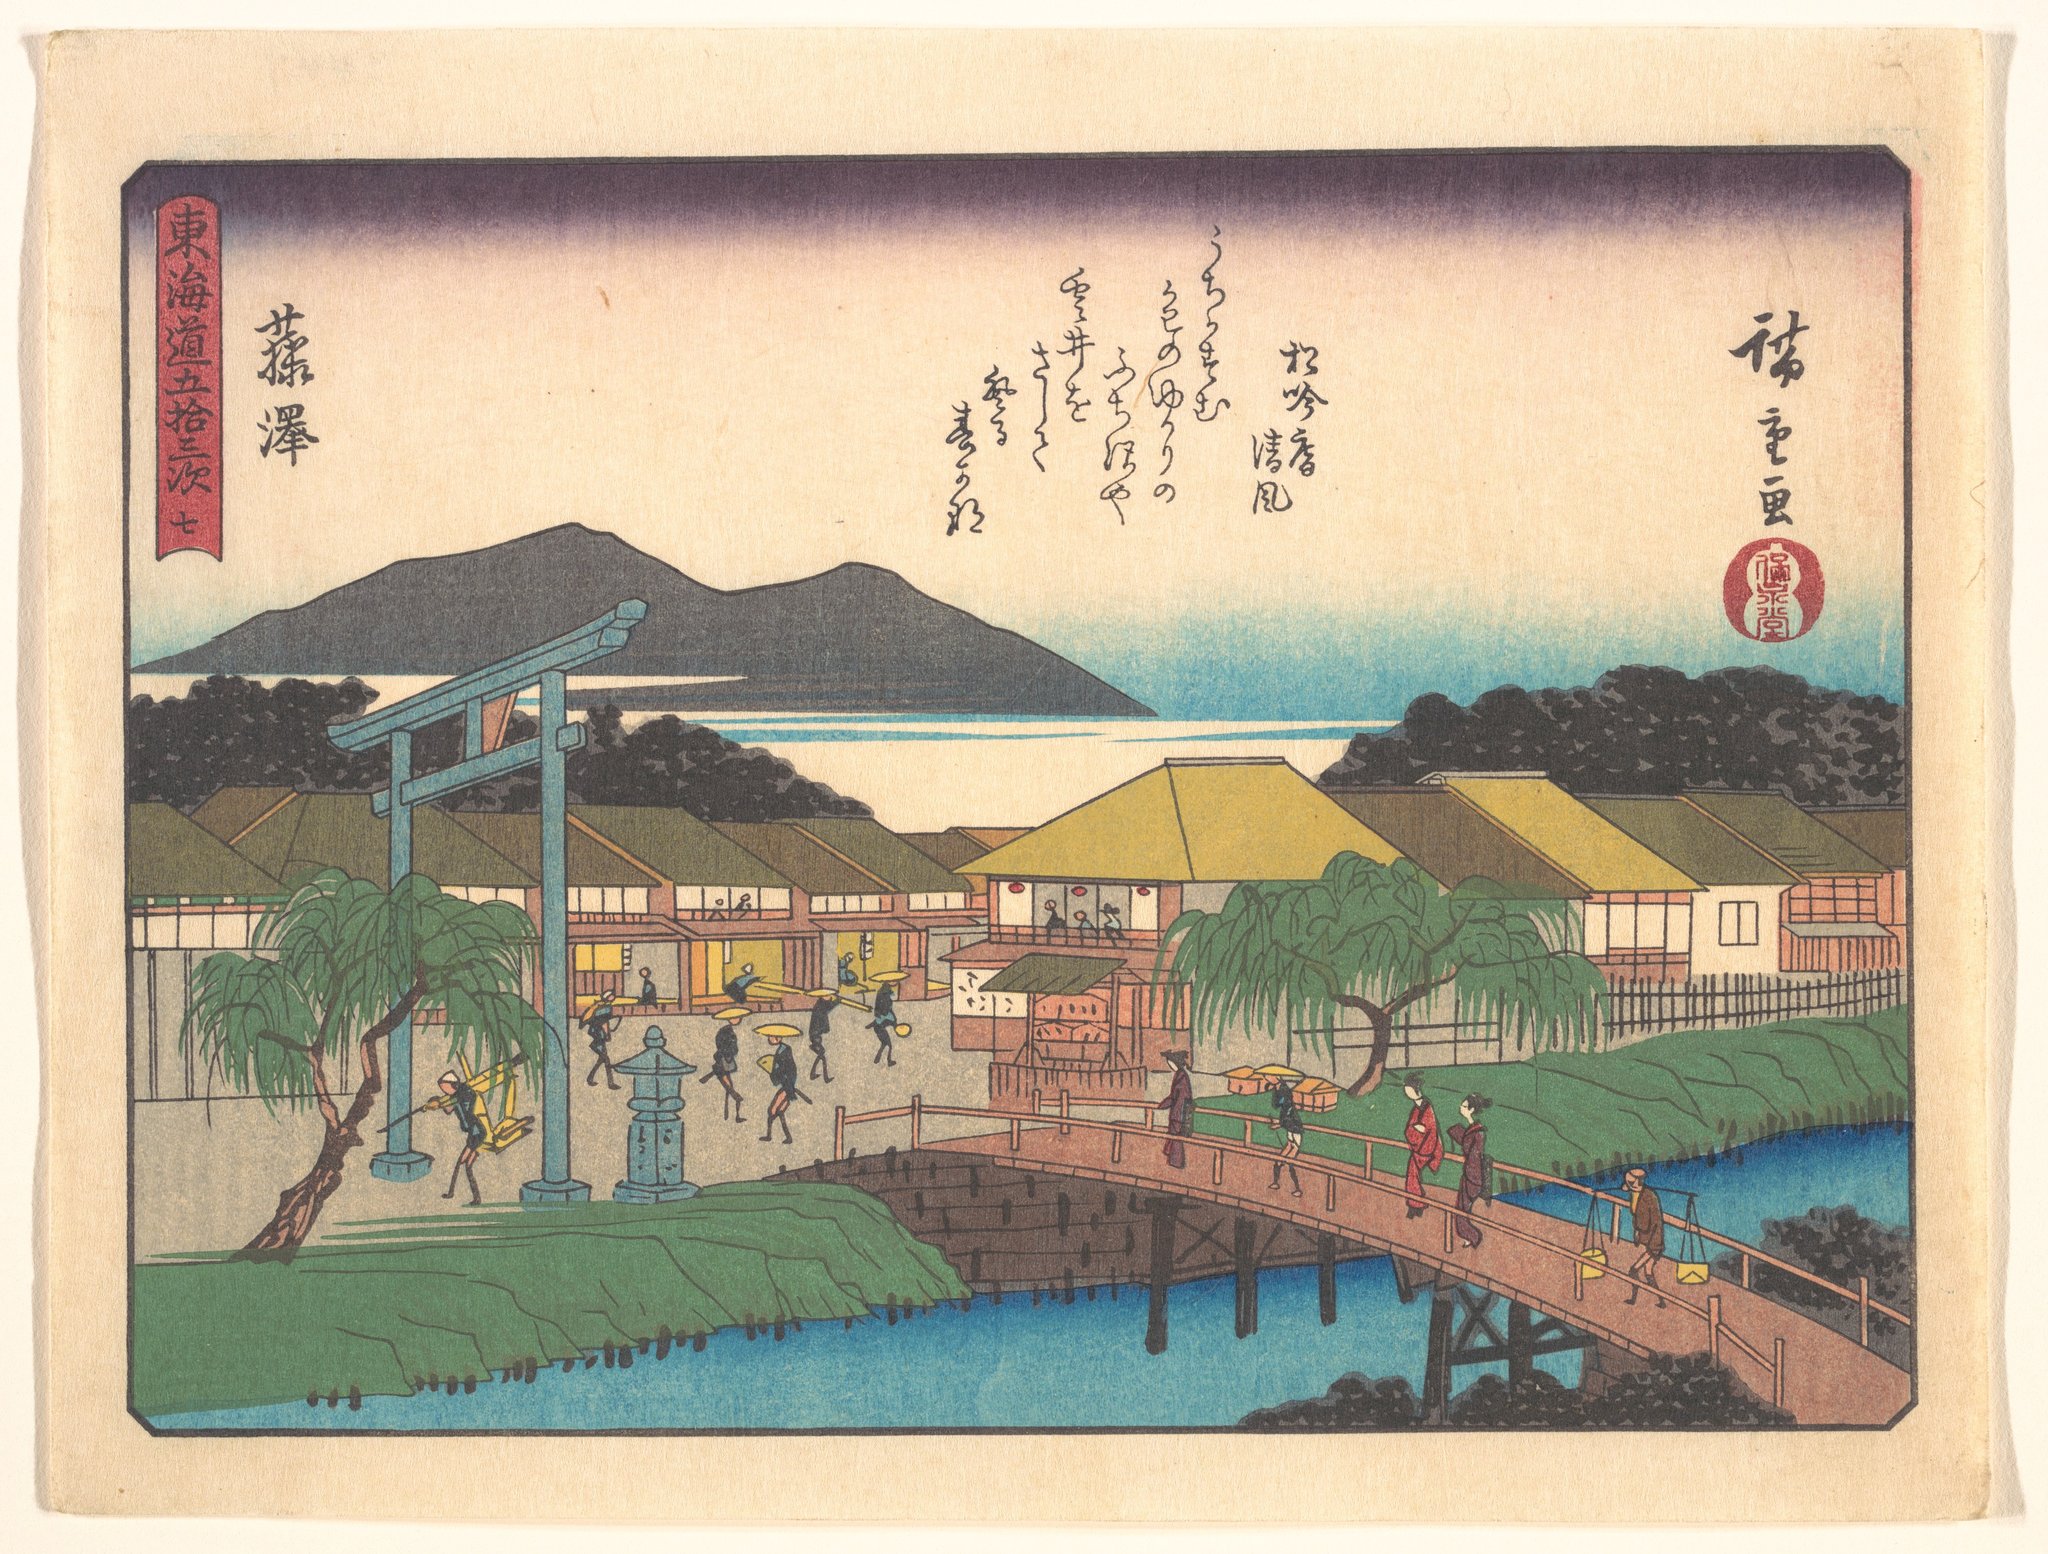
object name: print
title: 東海道五十三次 藤澤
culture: japanese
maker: utagawa hiroshige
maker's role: artist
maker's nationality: japanese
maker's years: 1797-1858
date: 1901-1933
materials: ink, paper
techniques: woodblock print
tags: buildings,gates,bridges,mountains